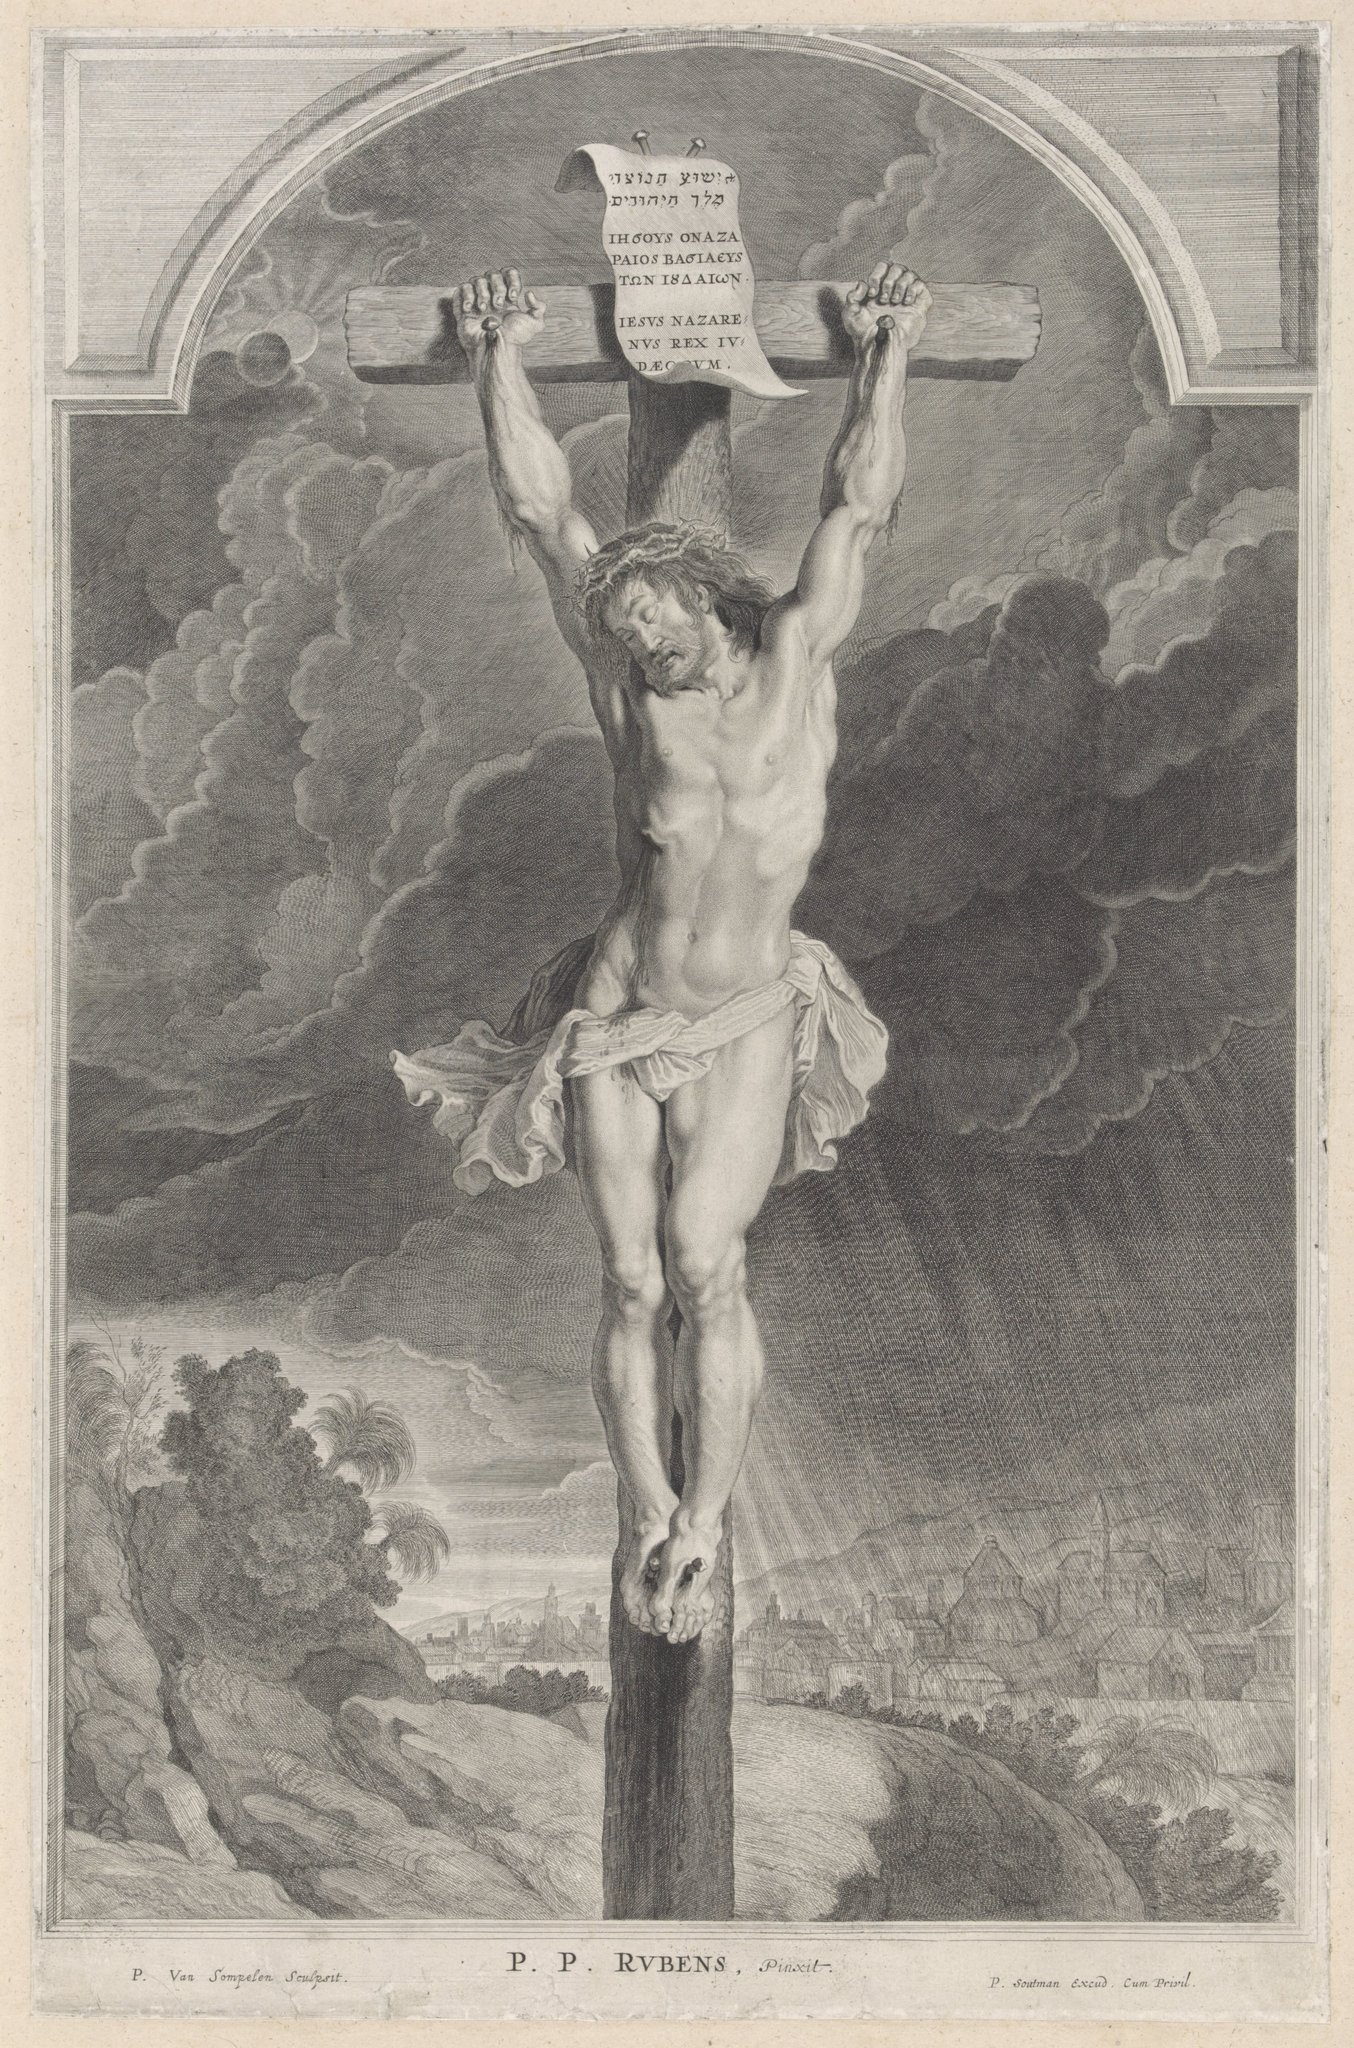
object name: print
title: Kruisiging van Christus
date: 1616-1624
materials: paper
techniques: engraving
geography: antwerp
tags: christ on the cross on golgotha (alone, without bystanders)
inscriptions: collector's mark: Lugt 240